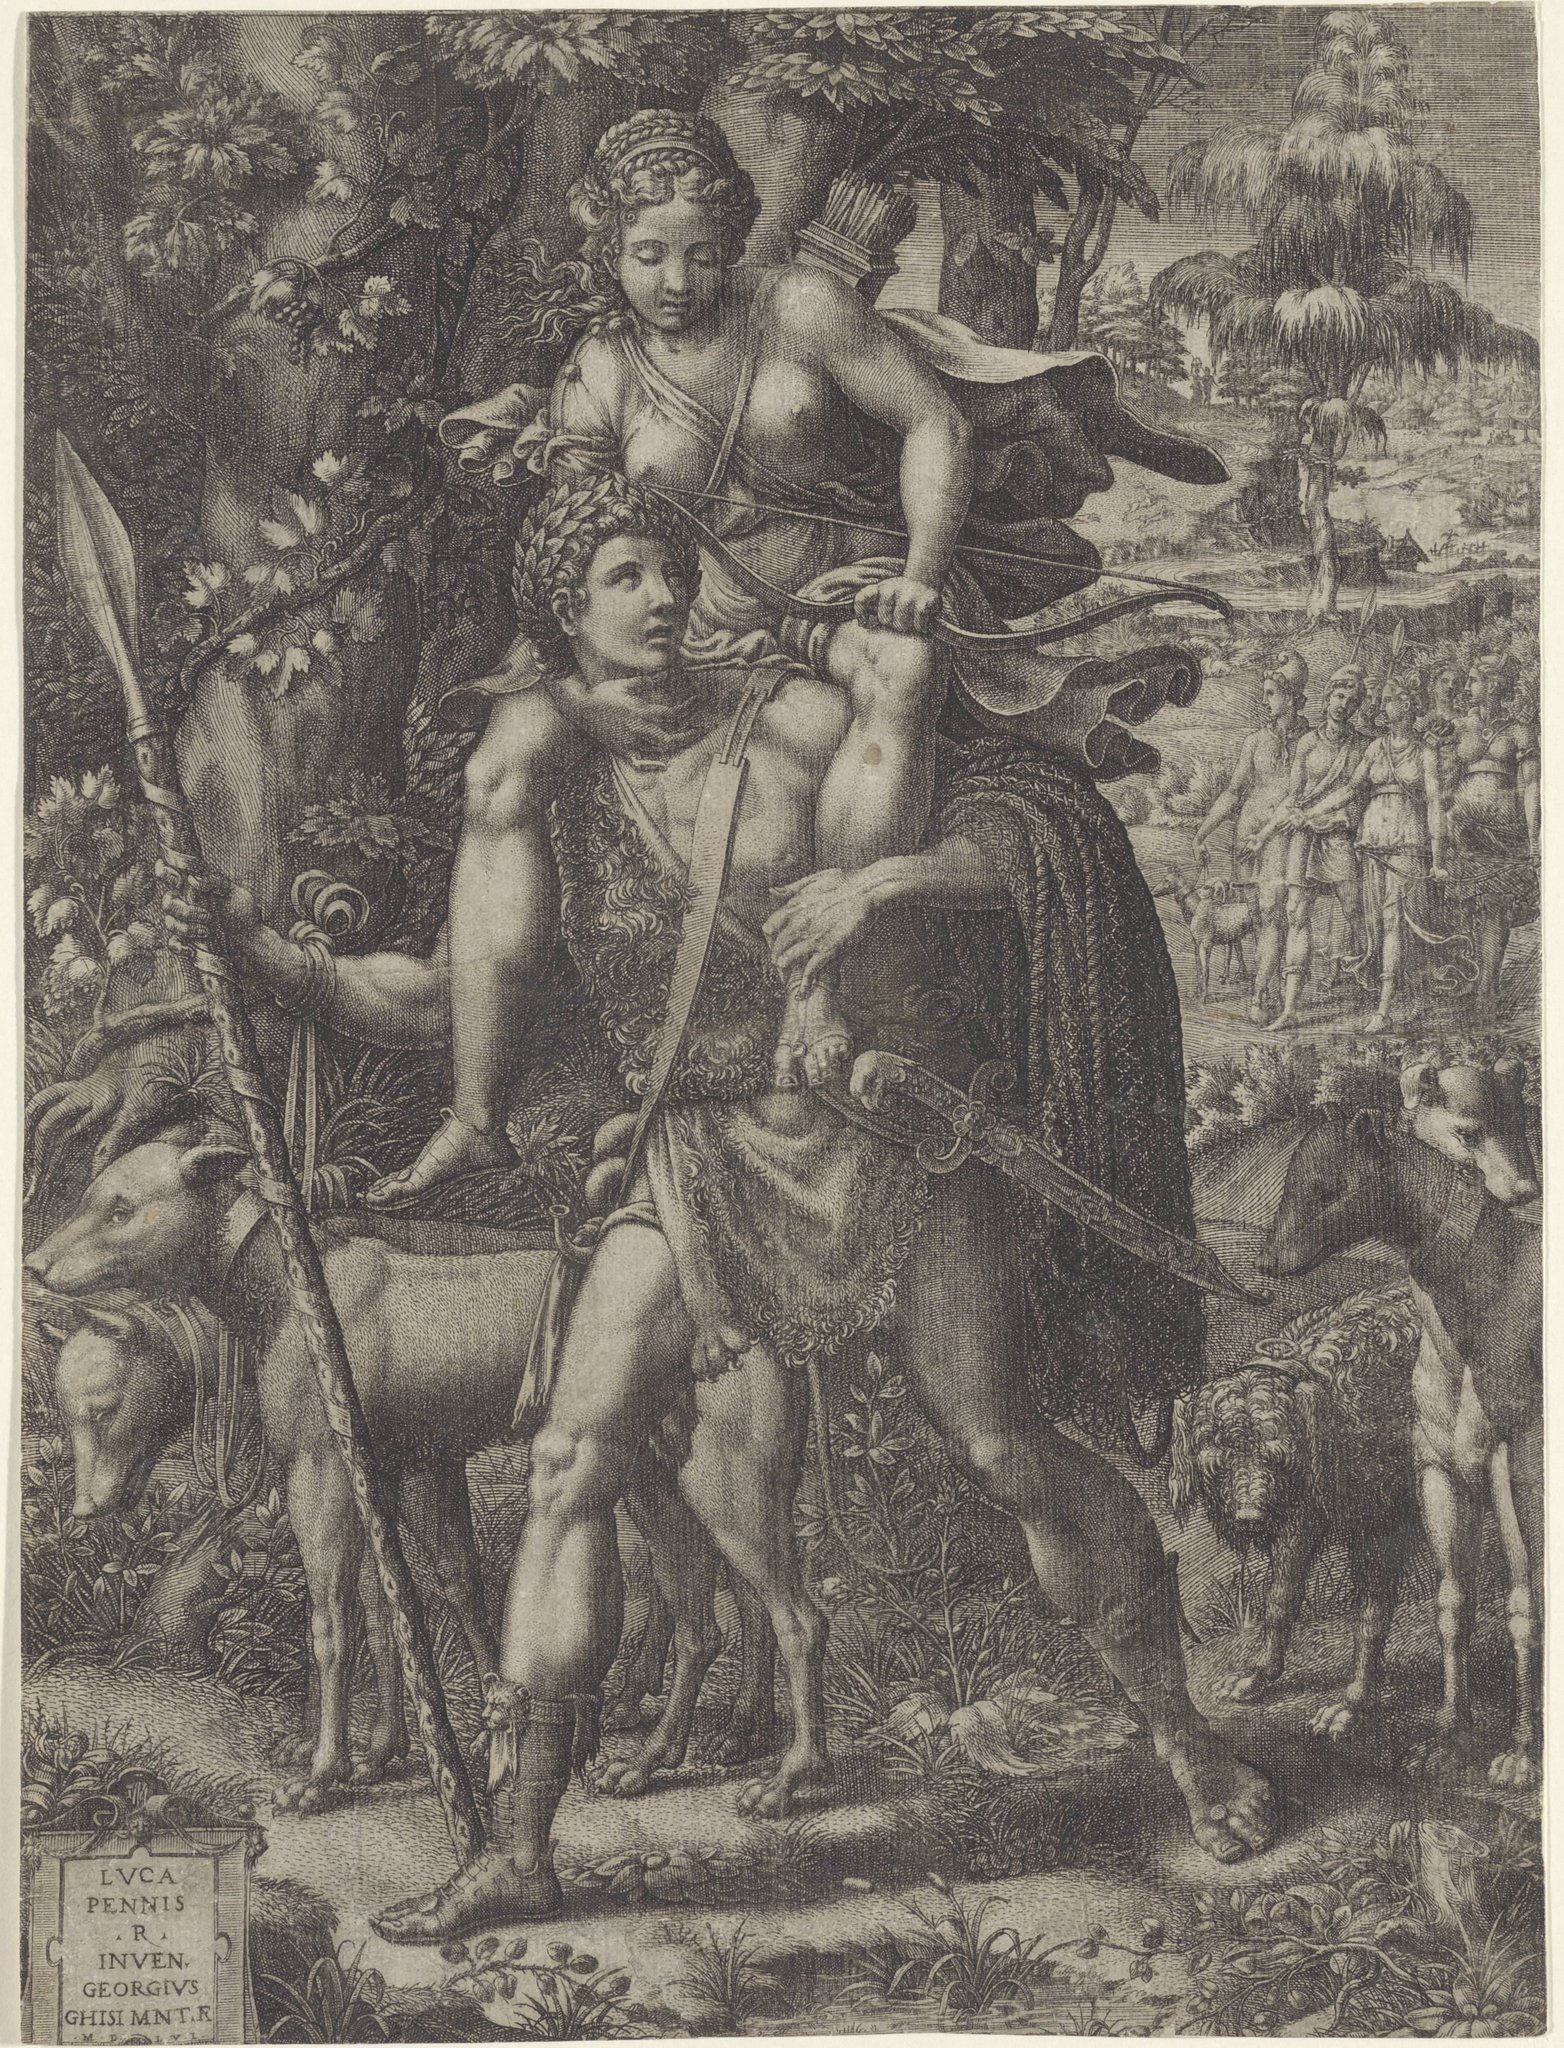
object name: print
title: Allegoria della caccia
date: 1556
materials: paper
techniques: engraving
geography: italy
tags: diana hunting, orion hunting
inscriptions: date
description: De jager Orion draagt Diana, de godin van de jacht, op zijn rug. Samen gaan zij op jacht met jachthonden. Op de achtergrond Diana's nimfen.